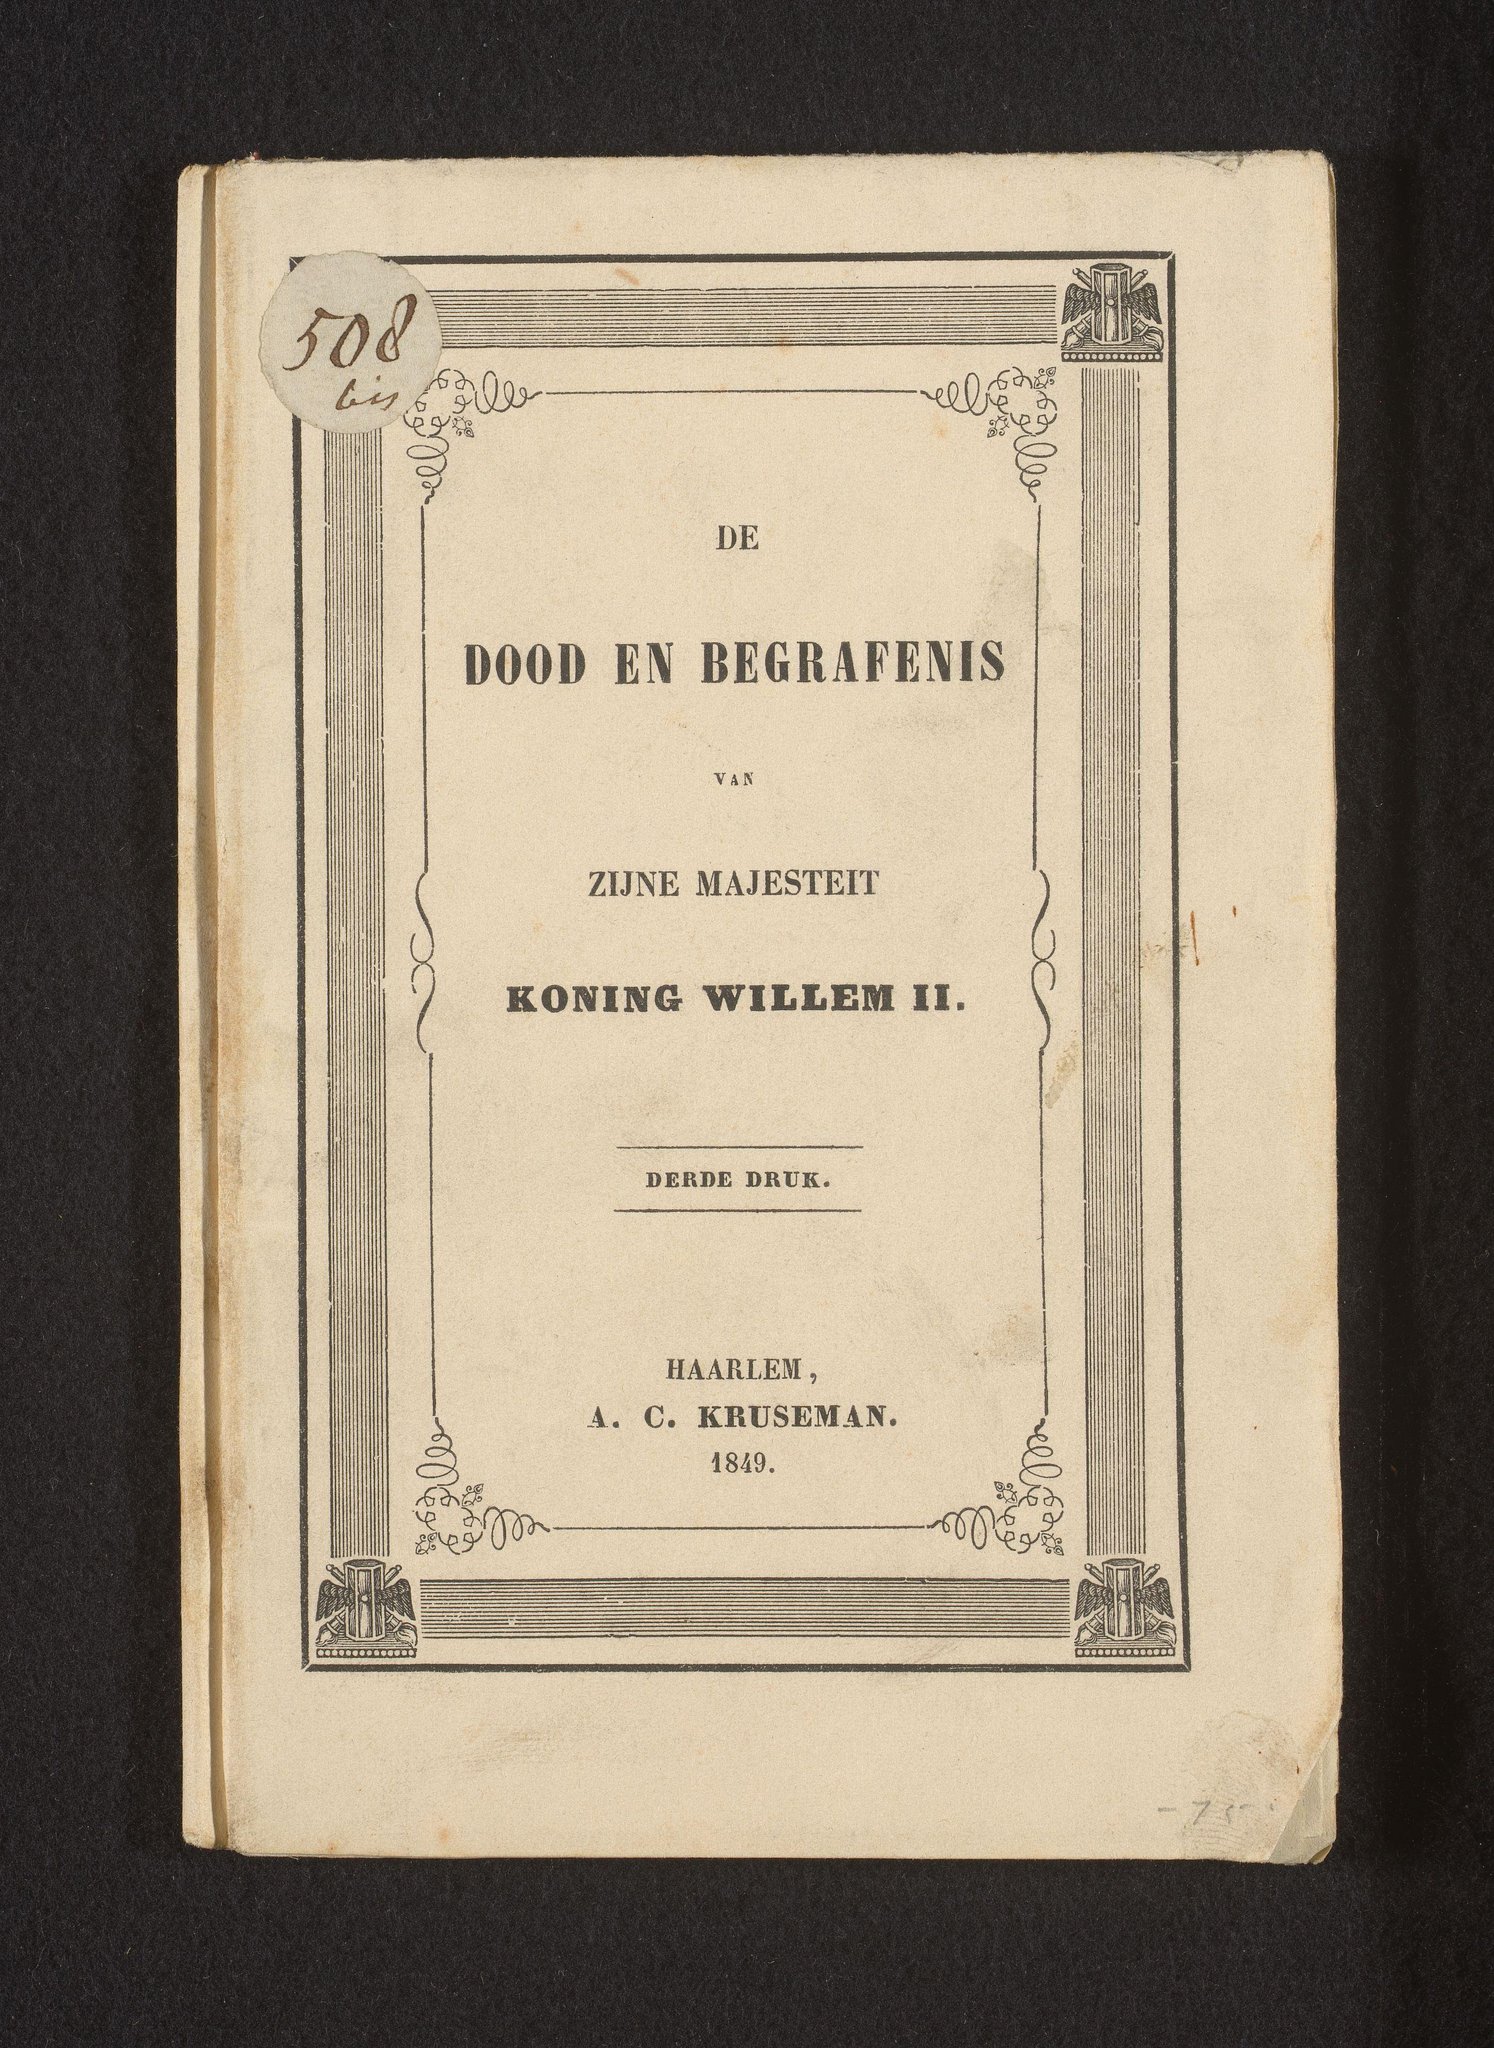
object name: brochure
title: De Dood en Begrafenis van Zijne Koning Willem II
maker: arie cornelis kruseman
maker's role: bookseller, printer, publisher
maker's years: 1818-1894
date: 1849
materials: paper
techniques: brocade, printing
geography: haarlem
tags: the hague, william ii of the netherlands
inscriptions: date